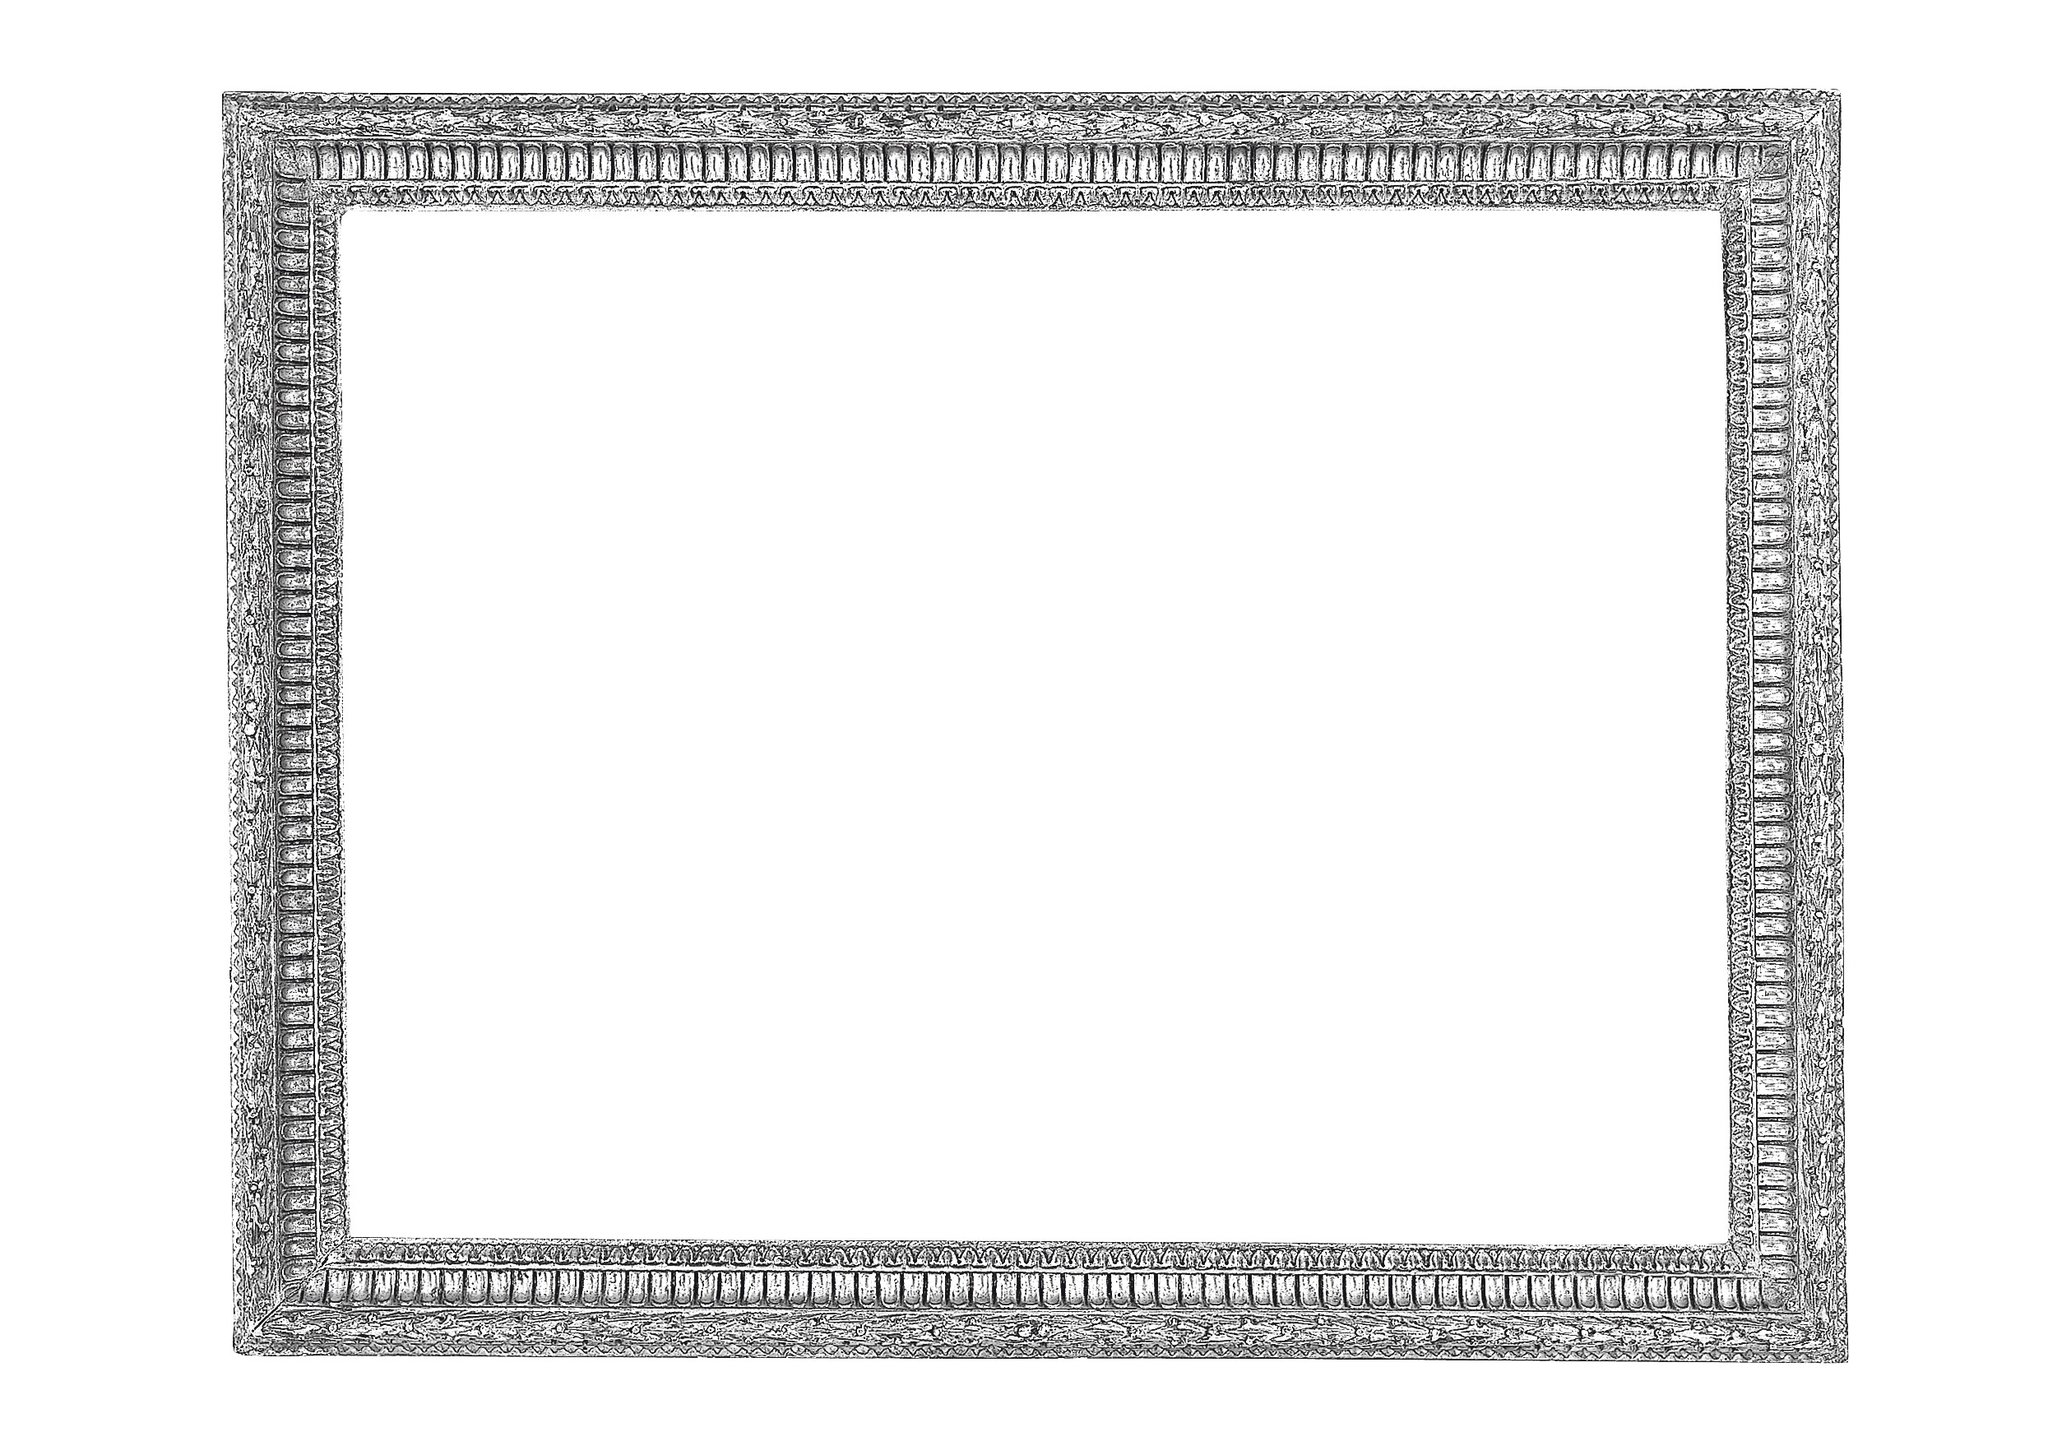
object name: frame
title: Neoclassical frame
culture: italian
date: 1780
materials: wood